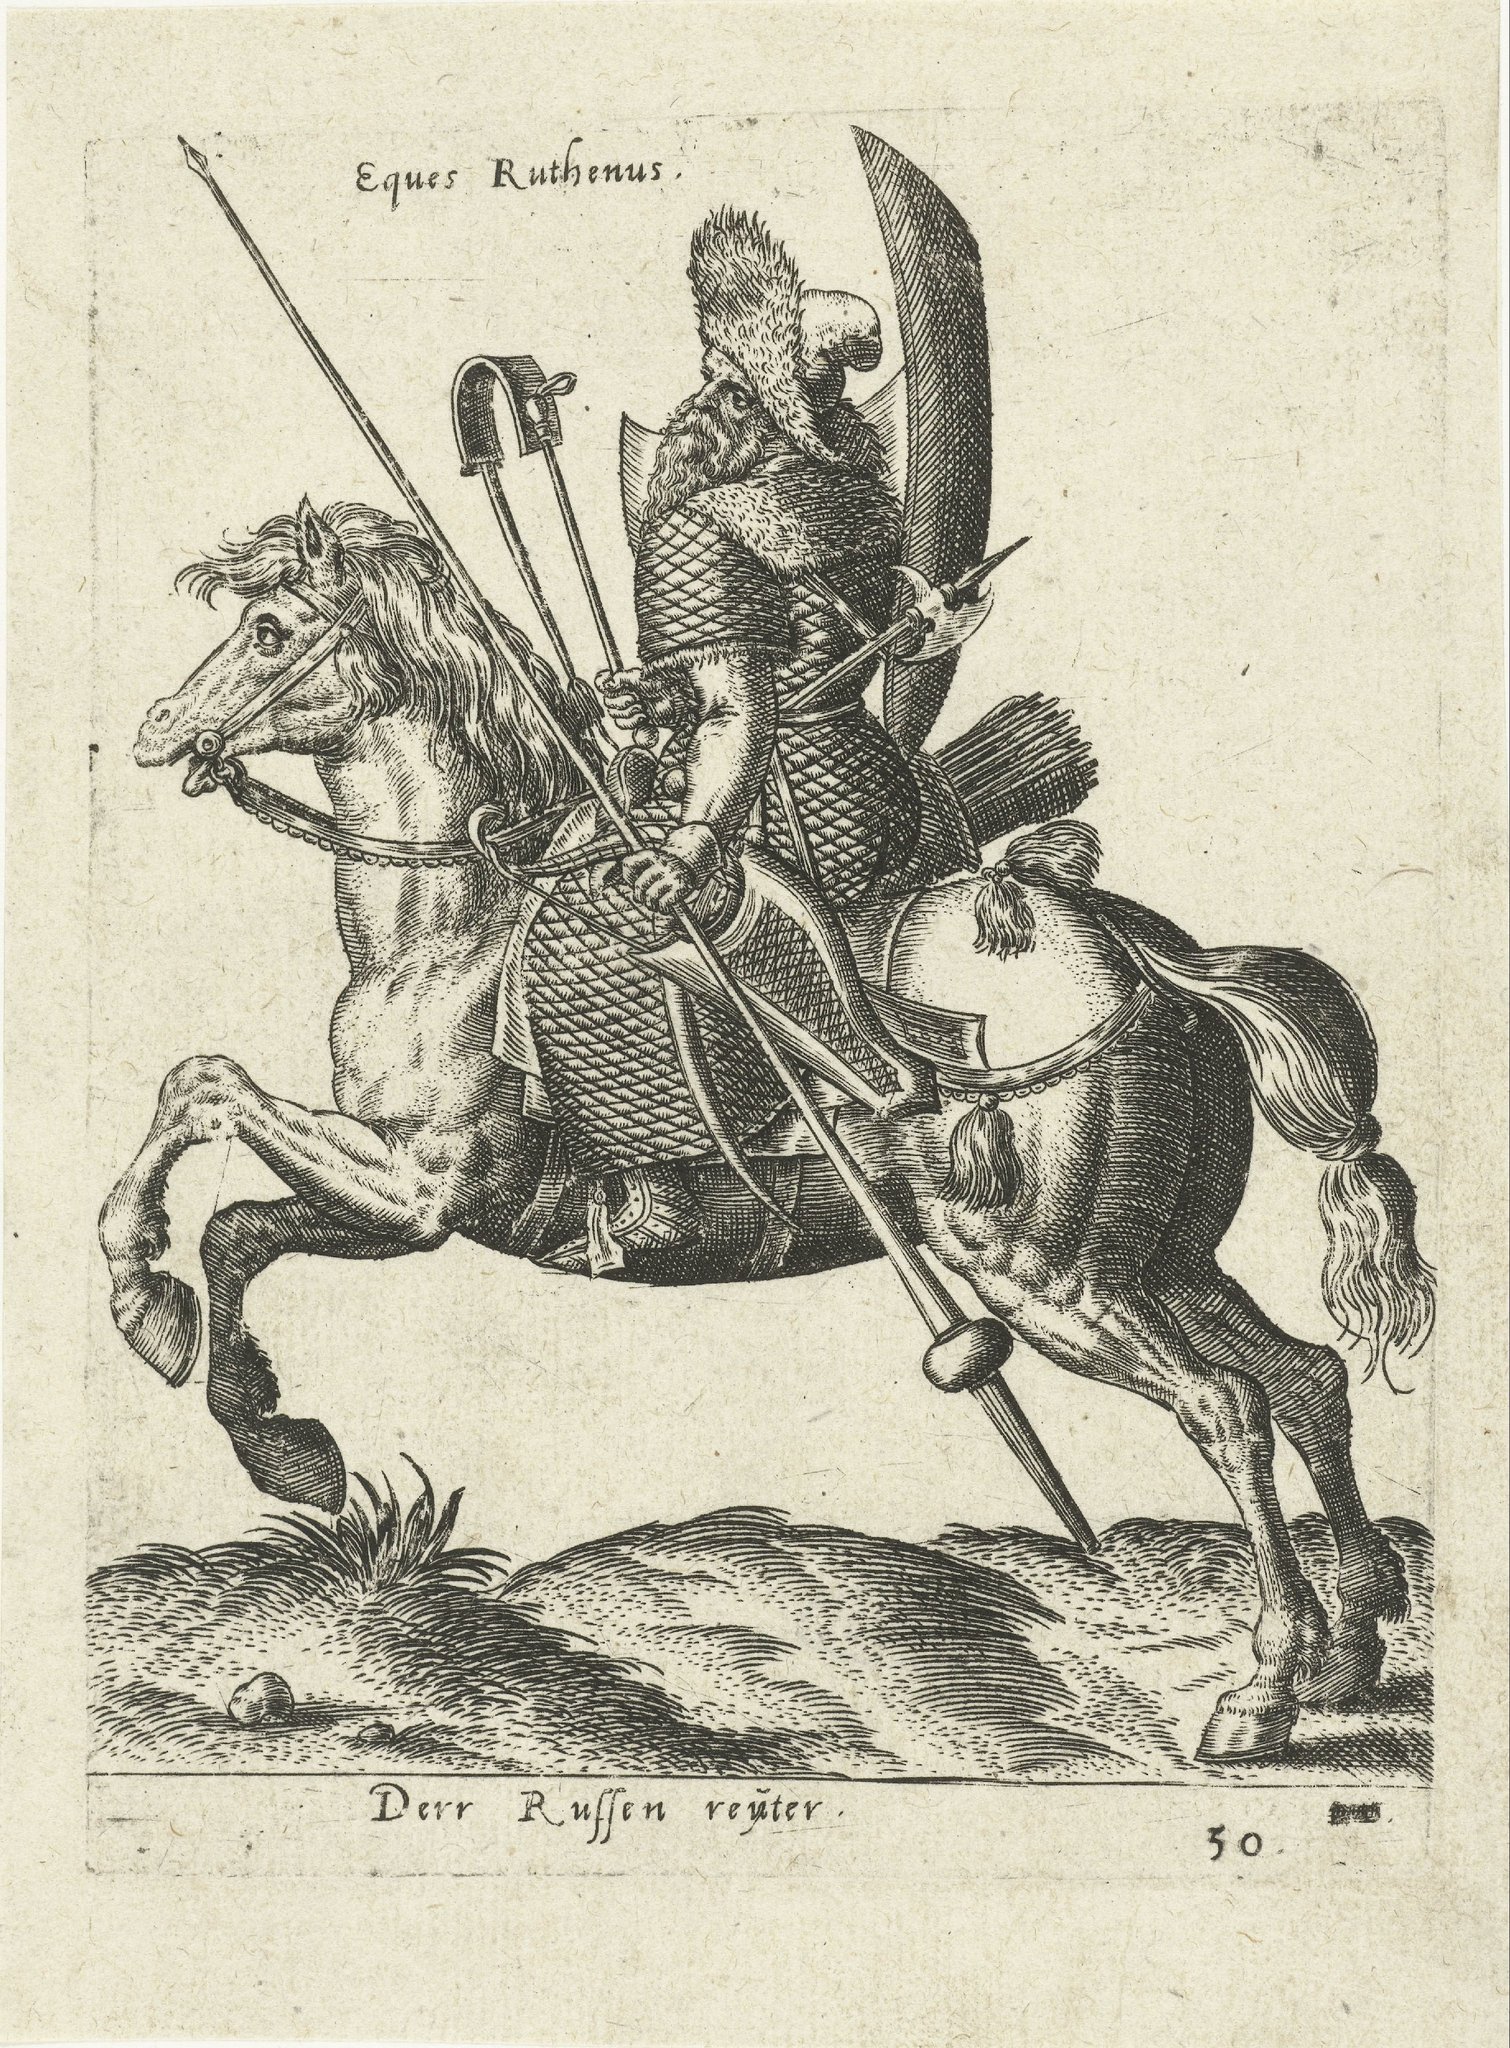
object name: costume print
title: Diversarum gentium armatura Equestris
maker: abraham de bruyn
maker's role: print maker, publisher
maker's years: 1540-1587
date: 1577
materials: paper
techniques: engraving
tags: warfare; military affairs (+ cavalry, horsemen), folk costume, regional costume, (military) uniforms, europeans (with name)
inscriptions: collector's mark: Lugt 2228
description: Paard en ruiter naar links. Het paard is in galop. De ruiter is Russisch gekleed en heeft een speer in zijn handen. De prent heeft een Duits onderschrift en Latijns opschrift. Prent oorspronkelijk uit 'Equitum descripcio...', 1577.